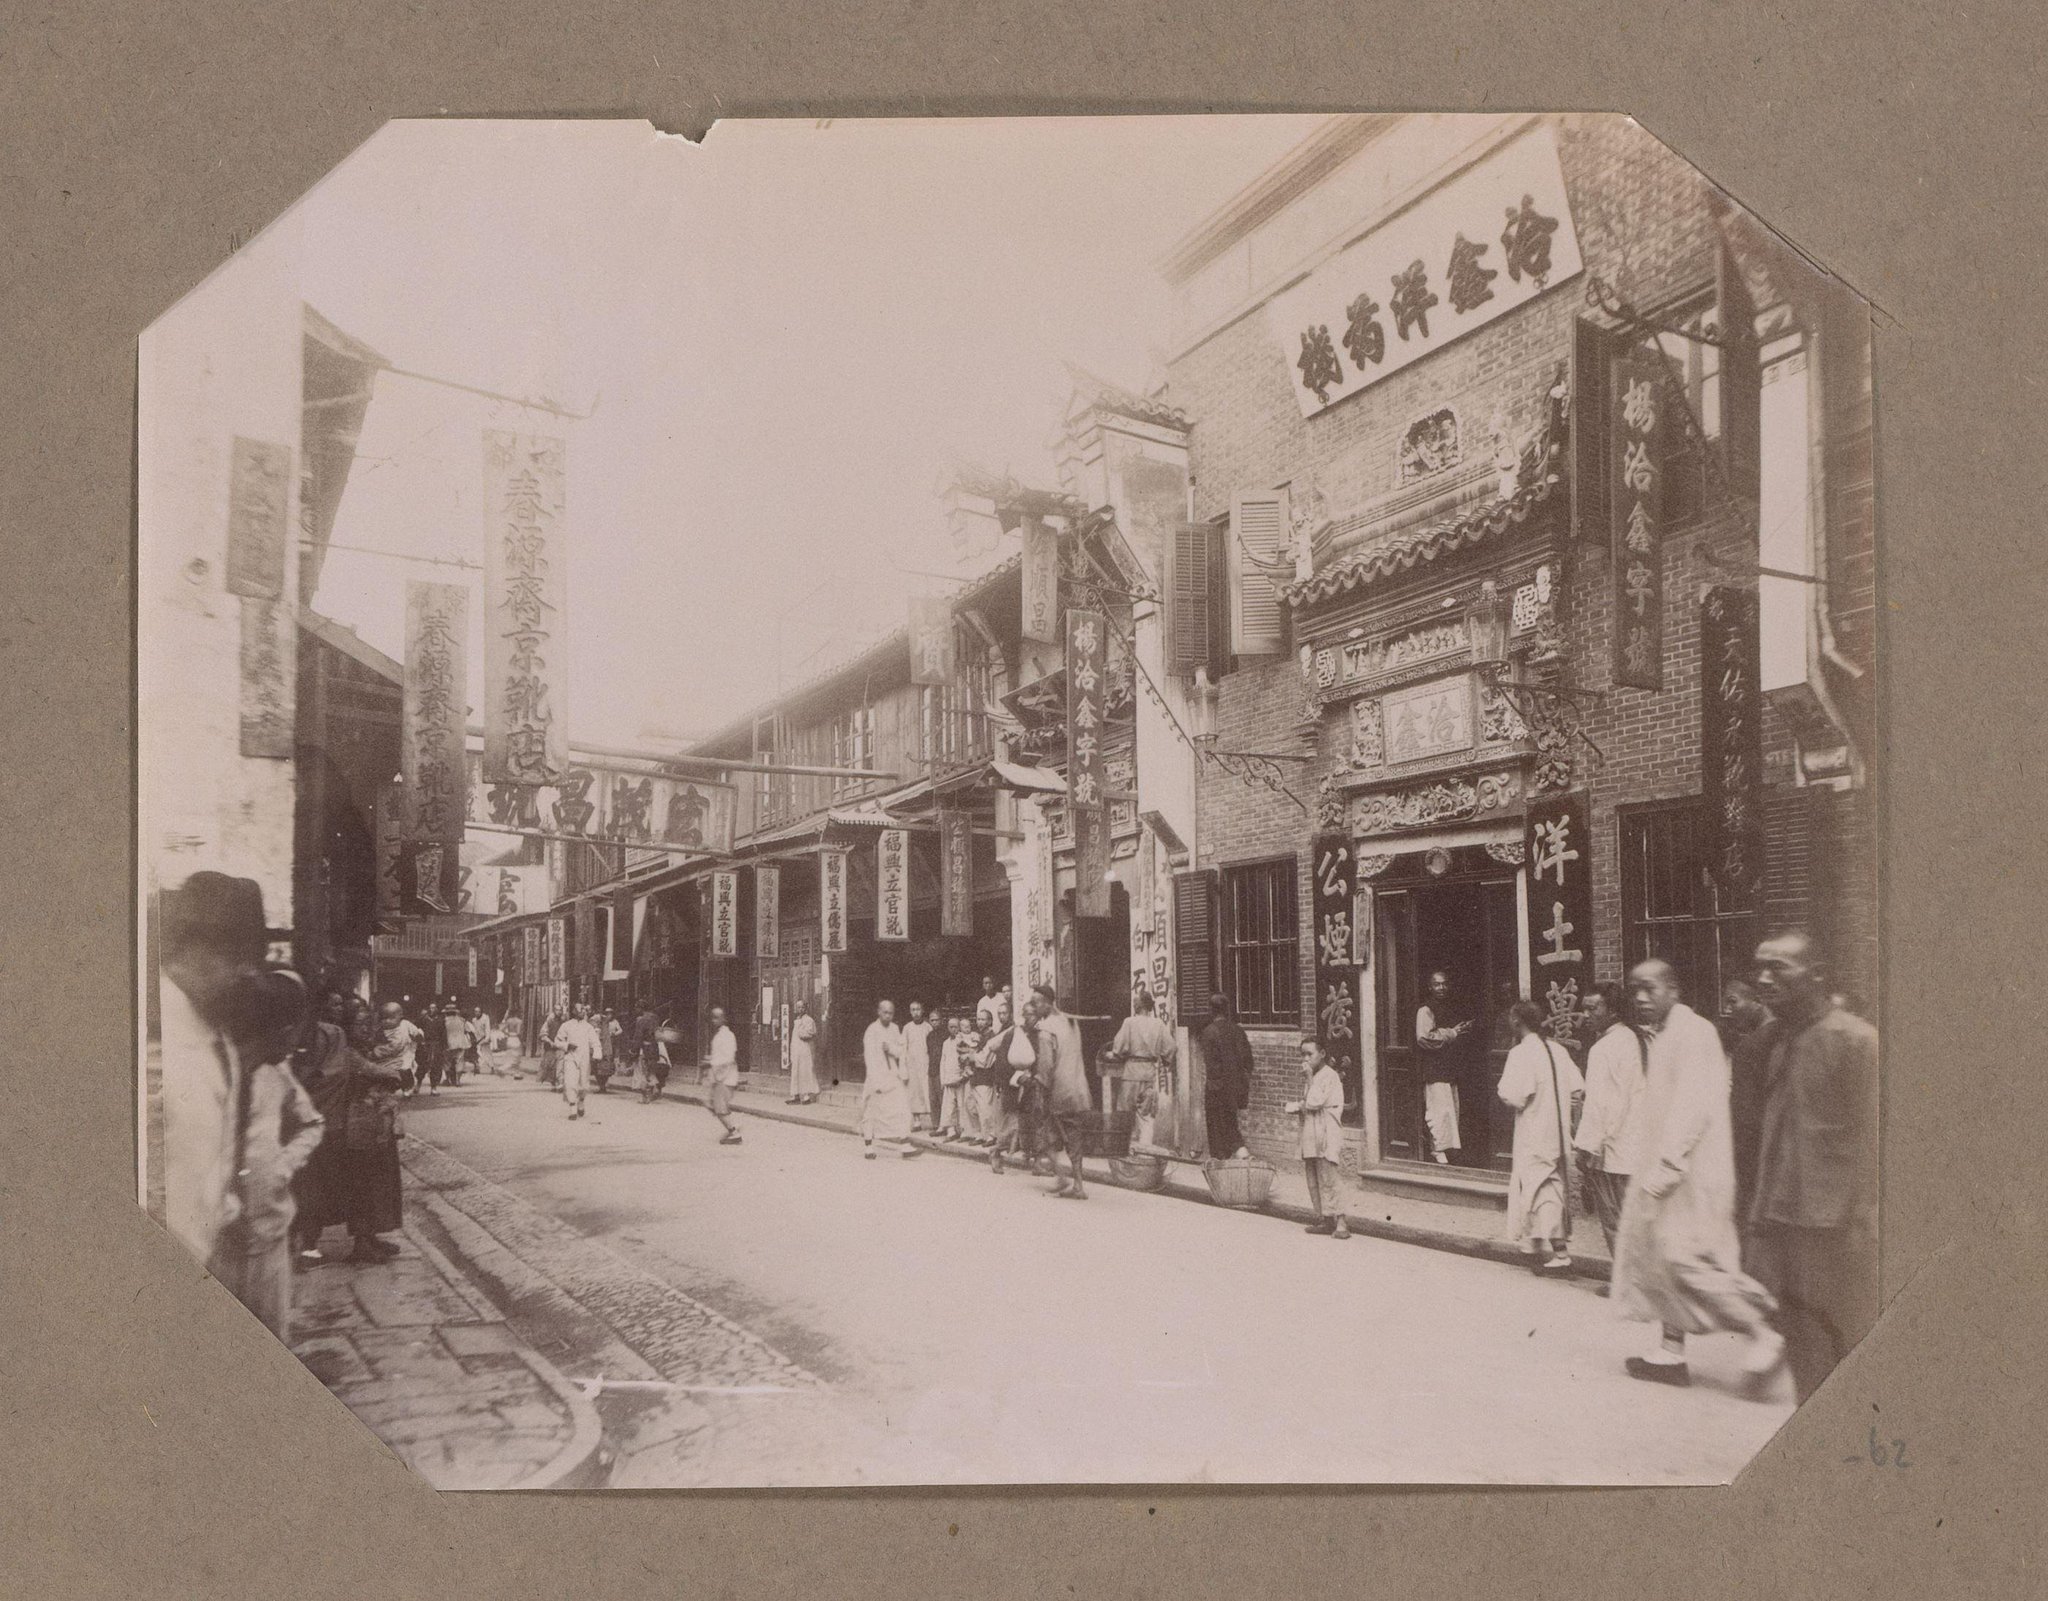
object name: photograph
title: Gezicht op een straat in China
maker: Anonymous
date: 1890-1903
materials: paper, photographic support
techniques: albumen print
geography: china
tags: façade (of house or building), street (+ city(-scape) with figures, staffage), china